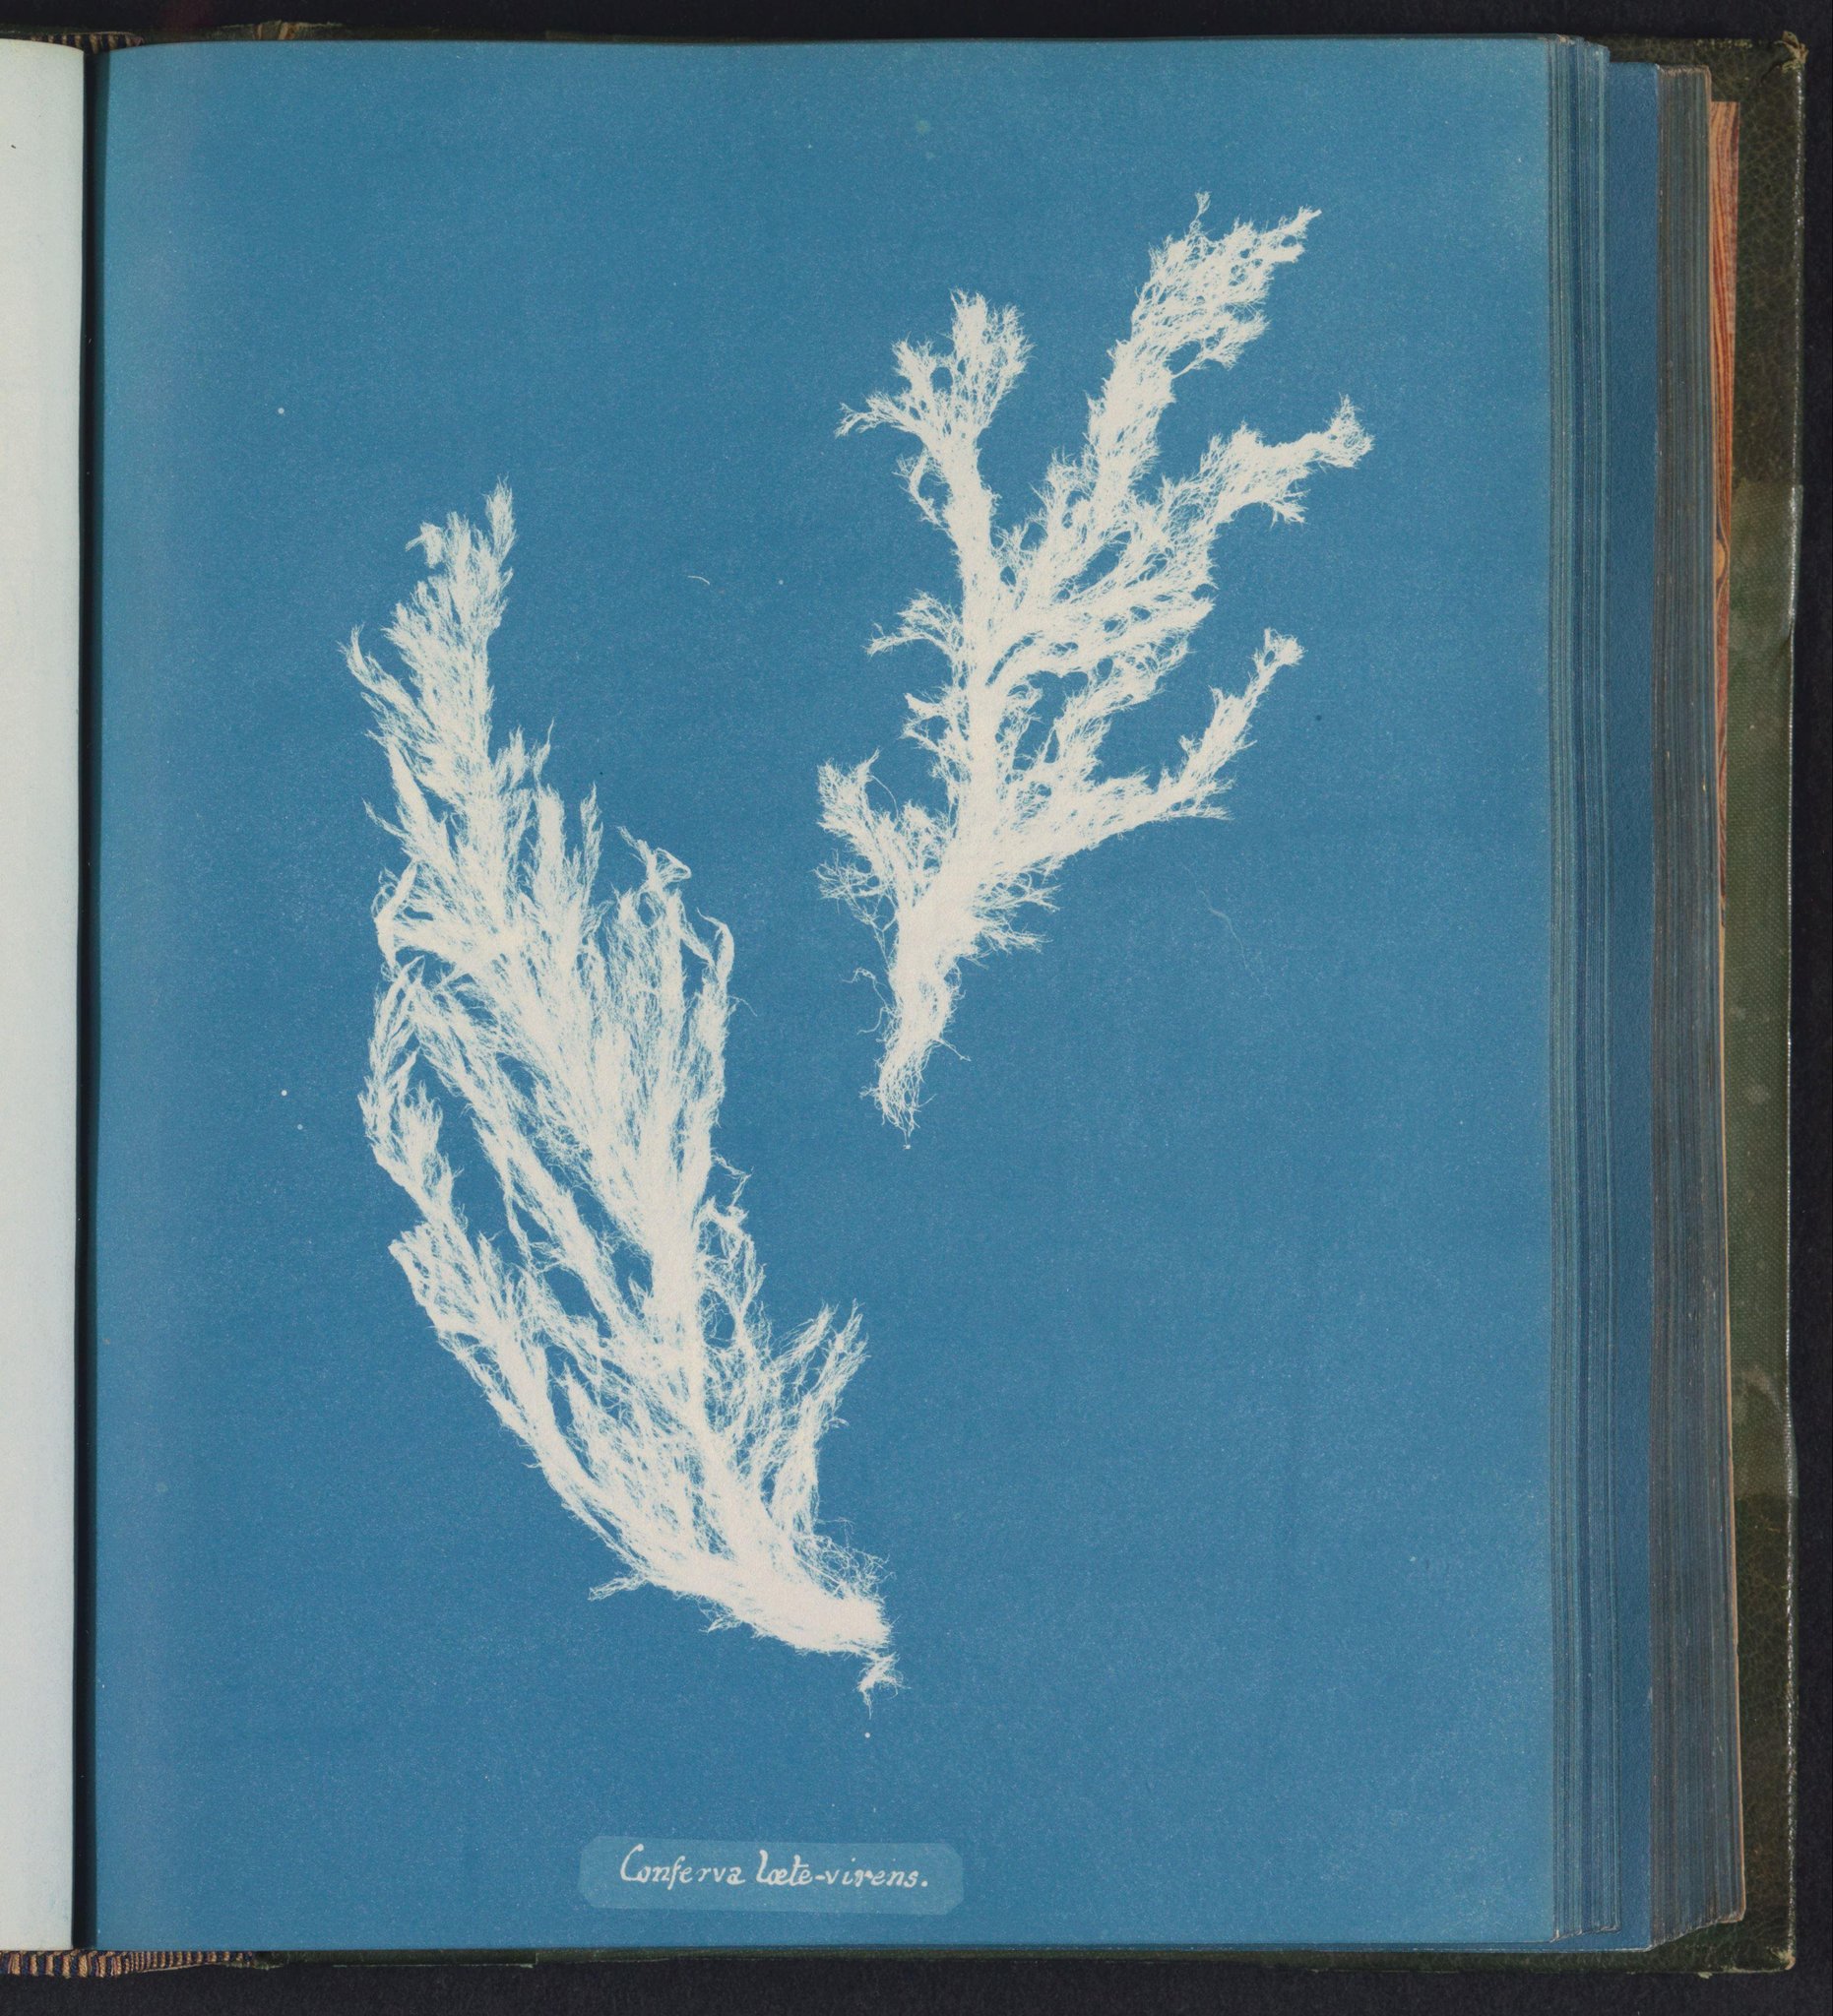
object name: photograph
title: Zeewier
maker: anna atkins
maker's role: fotograaf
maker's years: 1799-1871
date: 1843-1853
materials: photographic support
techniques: cyanotype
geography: united kingdom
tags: algae, seaweed